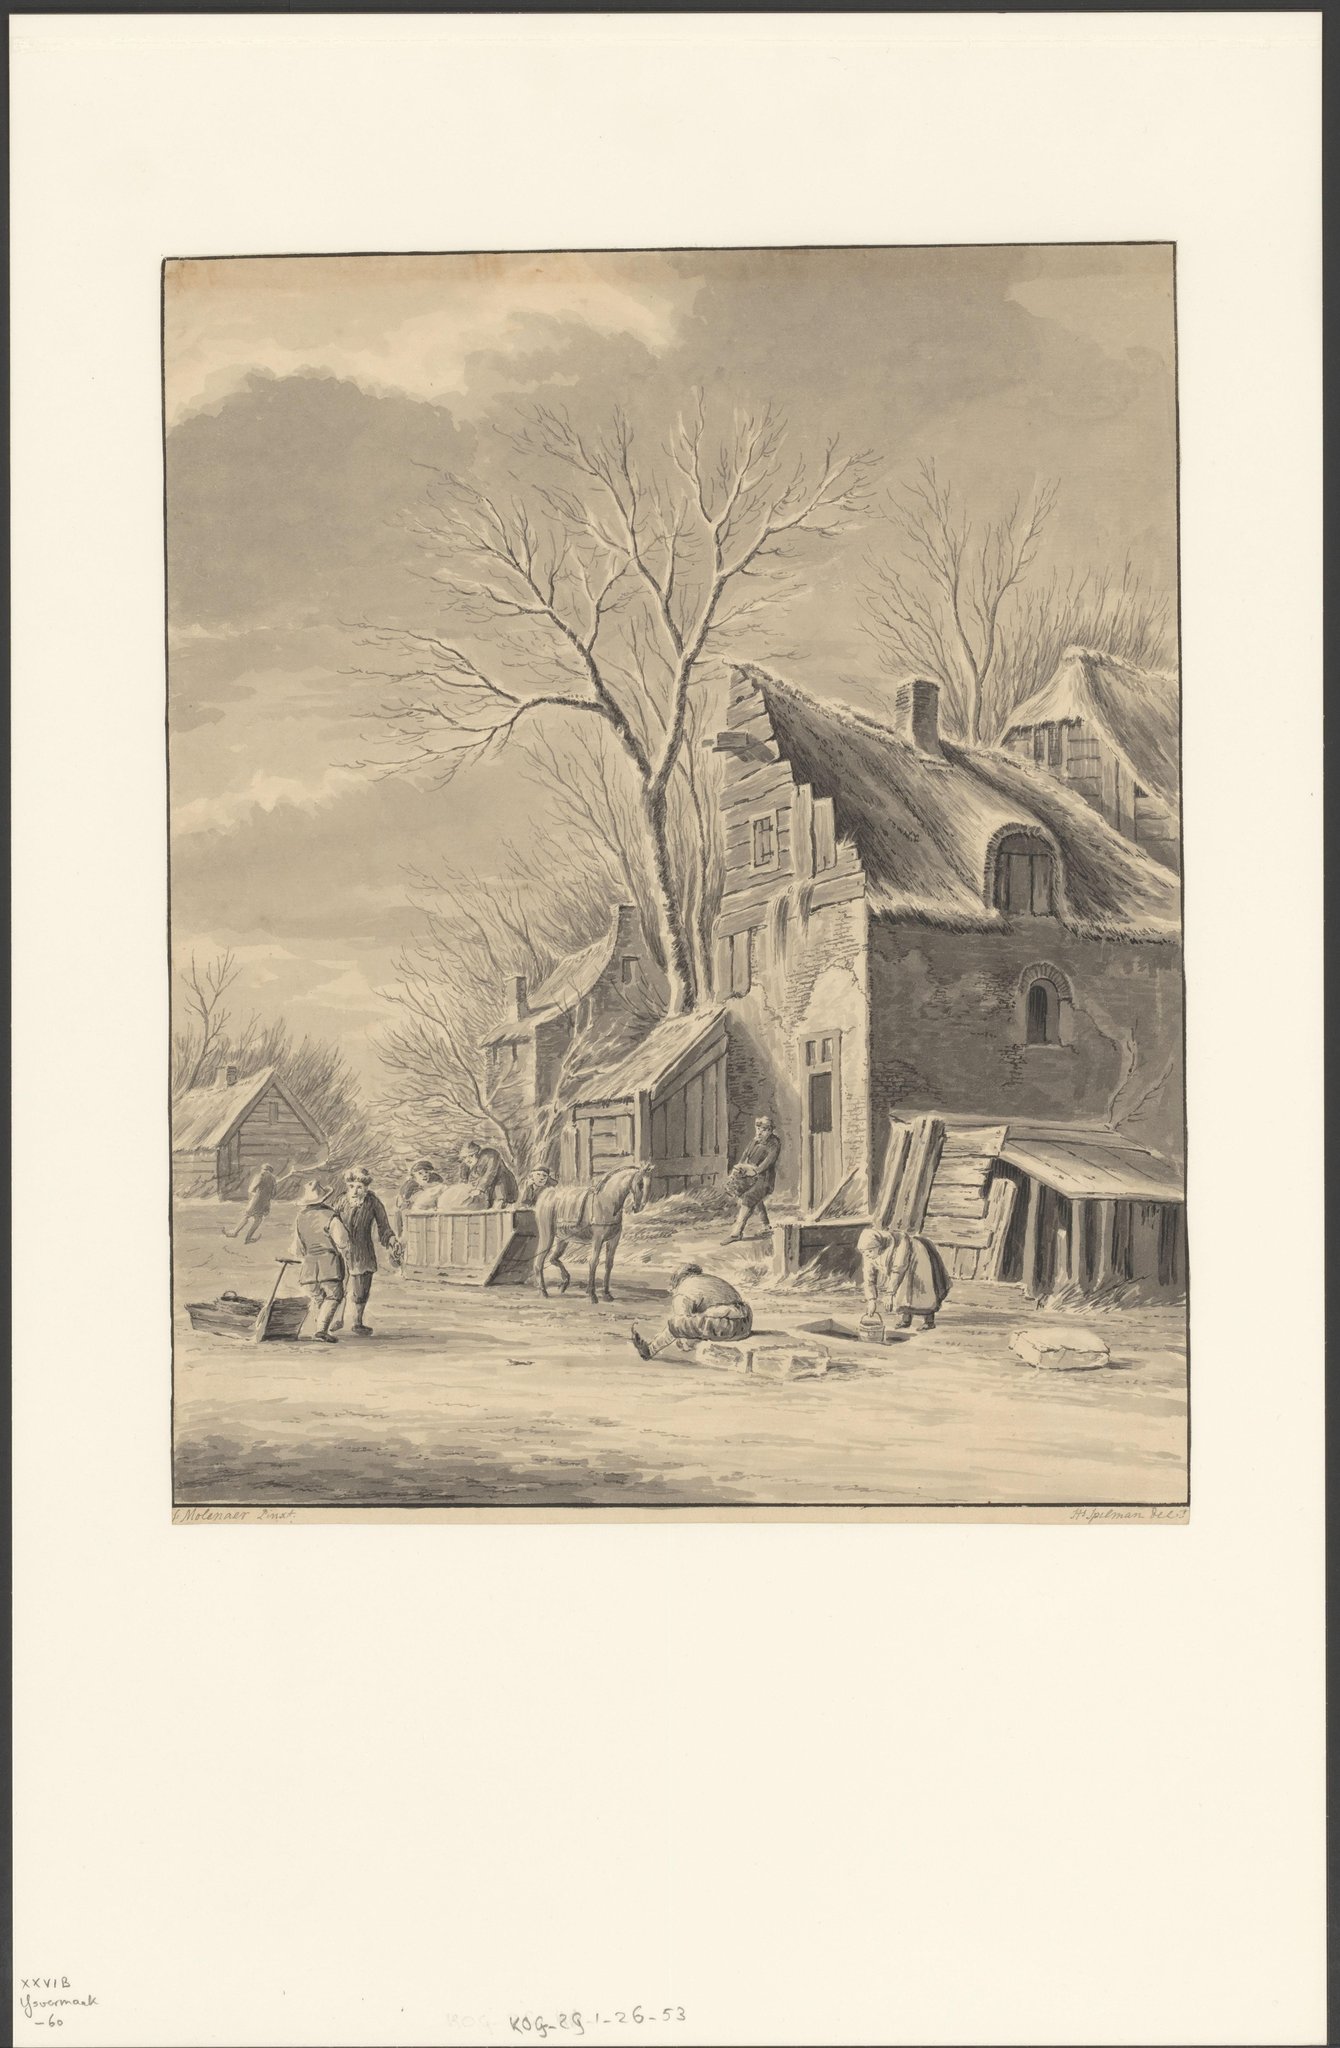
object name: drawing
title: Winterlandschap met paardenslee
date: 1731-1784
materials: ink, paper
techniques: brush, pen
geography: netherlands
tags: horse-sleigh, sleigh, sledge (non-sport), ice ~ freezing weather, skates (winter sports)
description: Winterlandschap met paardenslee, twee mannen met een bakslede, een man die schaatsen onderbindt en een vrouw die water haalt bij een bijt in het ijs. Op een bevroren vaart voor een woning. Onderwerpsrubrieken binnen de Atlas Zeden en Gewoonten: Spel en Vermaak; IJsvermaak, Teekeningen.